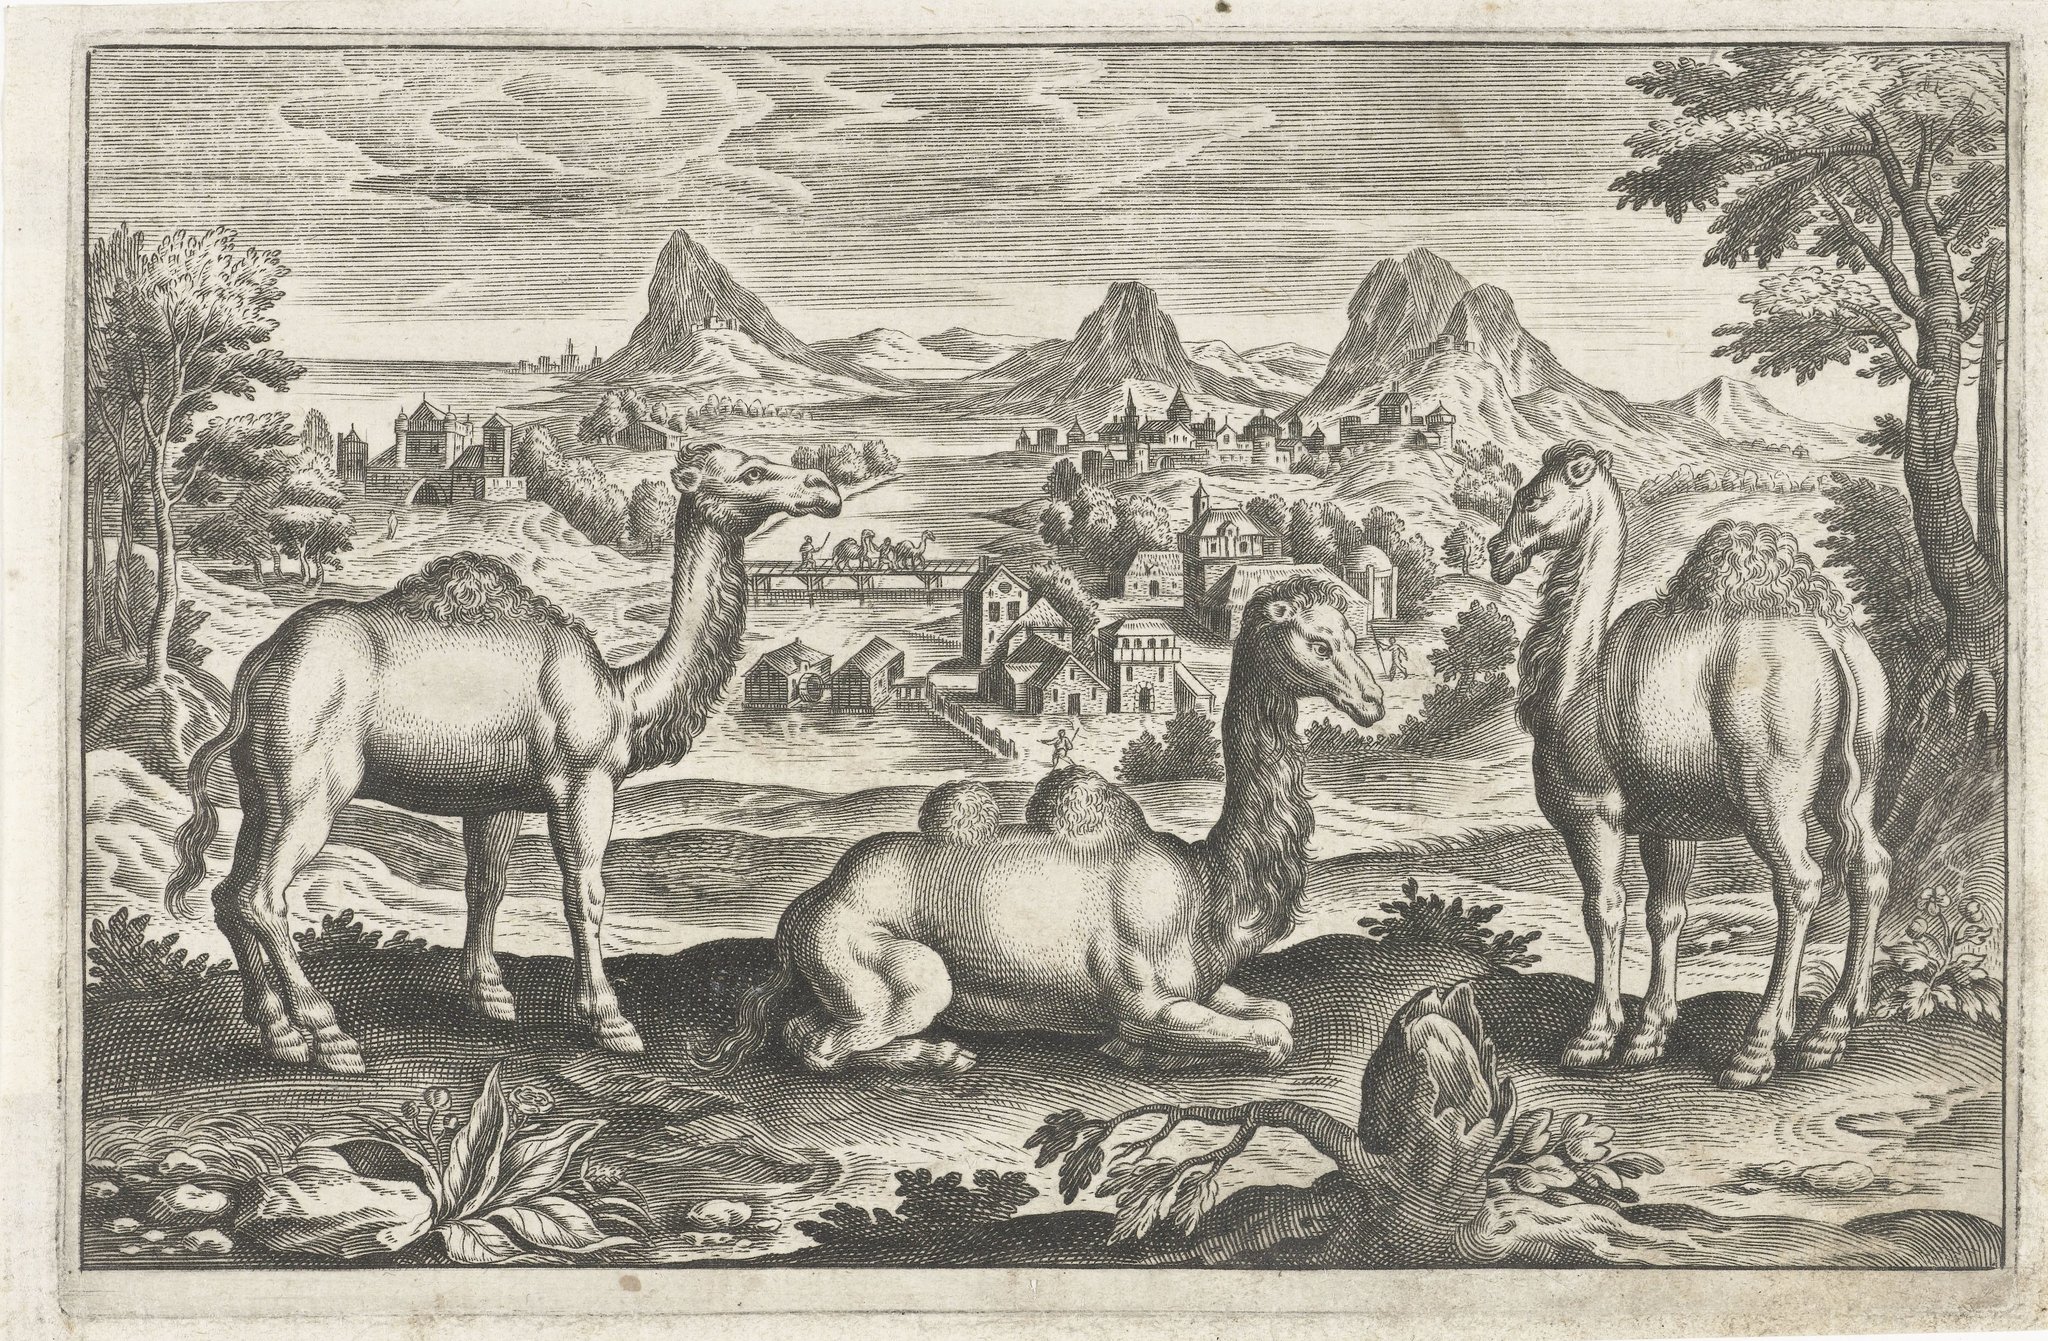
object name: print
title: Dromedarissen en een kameel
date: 1595-1652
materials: paper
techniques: engraving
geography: amsterdam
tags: hoofed animals: camel, hoofed animals: dromedary, river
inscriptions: collector's mark: Lugt 2228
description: Op de voorgrond twee dromedarissen en een kameel. Op de achtergrond een berglandschap met een rivier. De prent maakt deel uit van een serie met dieren als onderwerp.